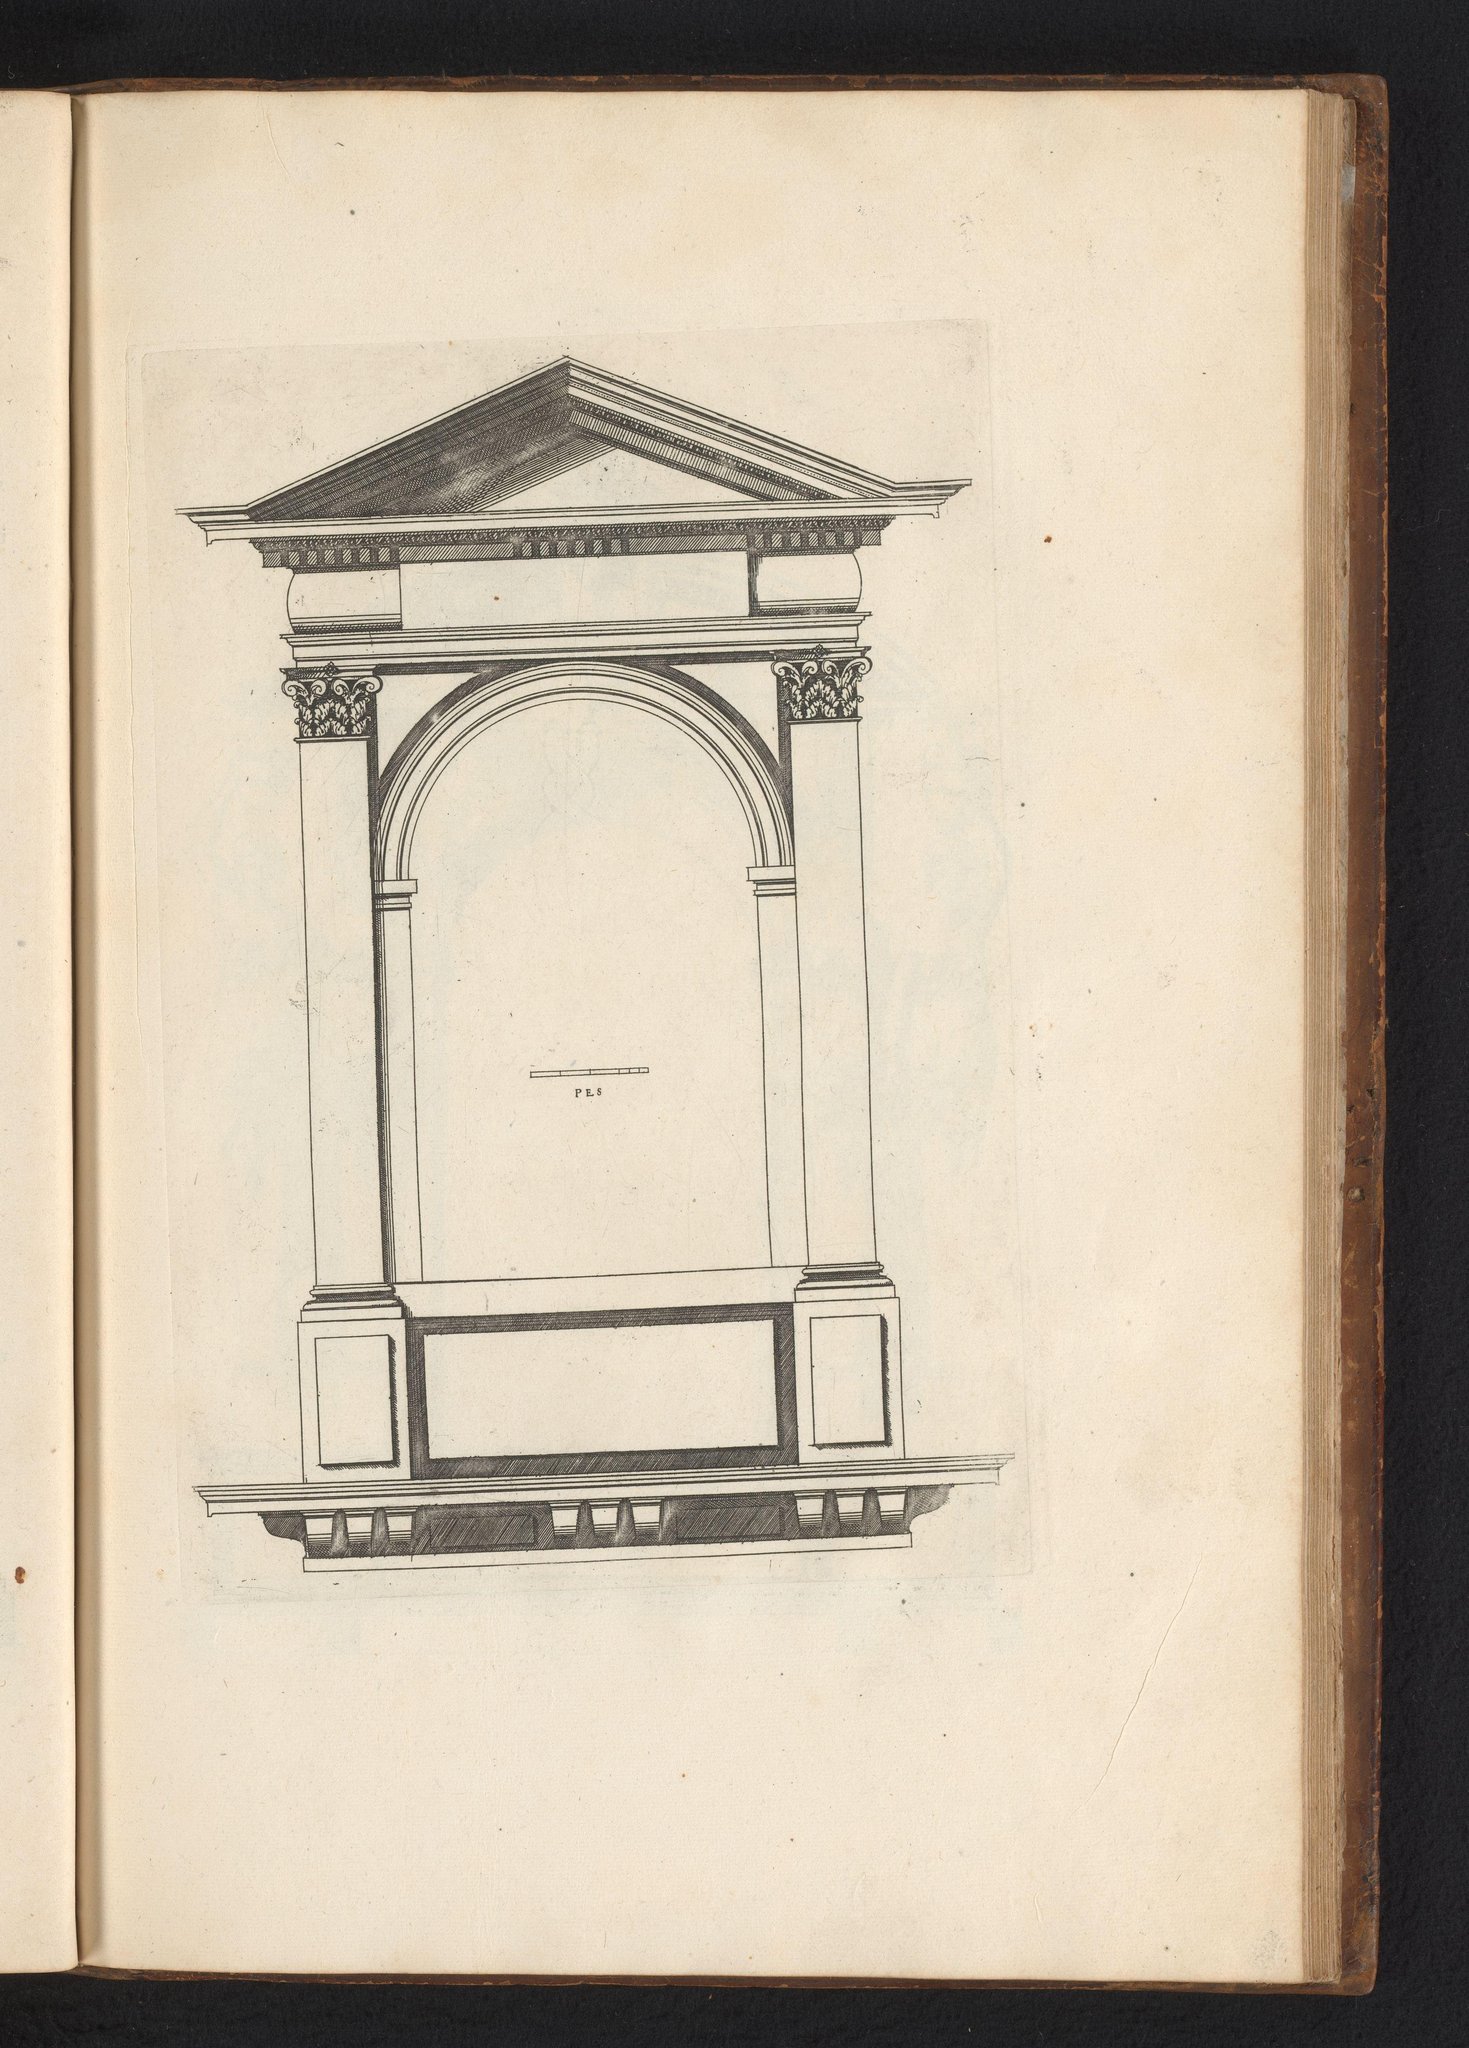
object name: ornament print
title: Venster met fronton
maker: jacques androuet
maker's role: draughtsman, print maker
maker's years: 1515-1584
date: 1561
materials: paper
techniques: etching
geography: paris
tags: window, other architectural details: pediment, architectural design or model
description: Venster met fronton. Onderdeel van 'Seconde livre d'architectvre' (1561): 64 etsen met geornamenteerde architectuuronderdelen.